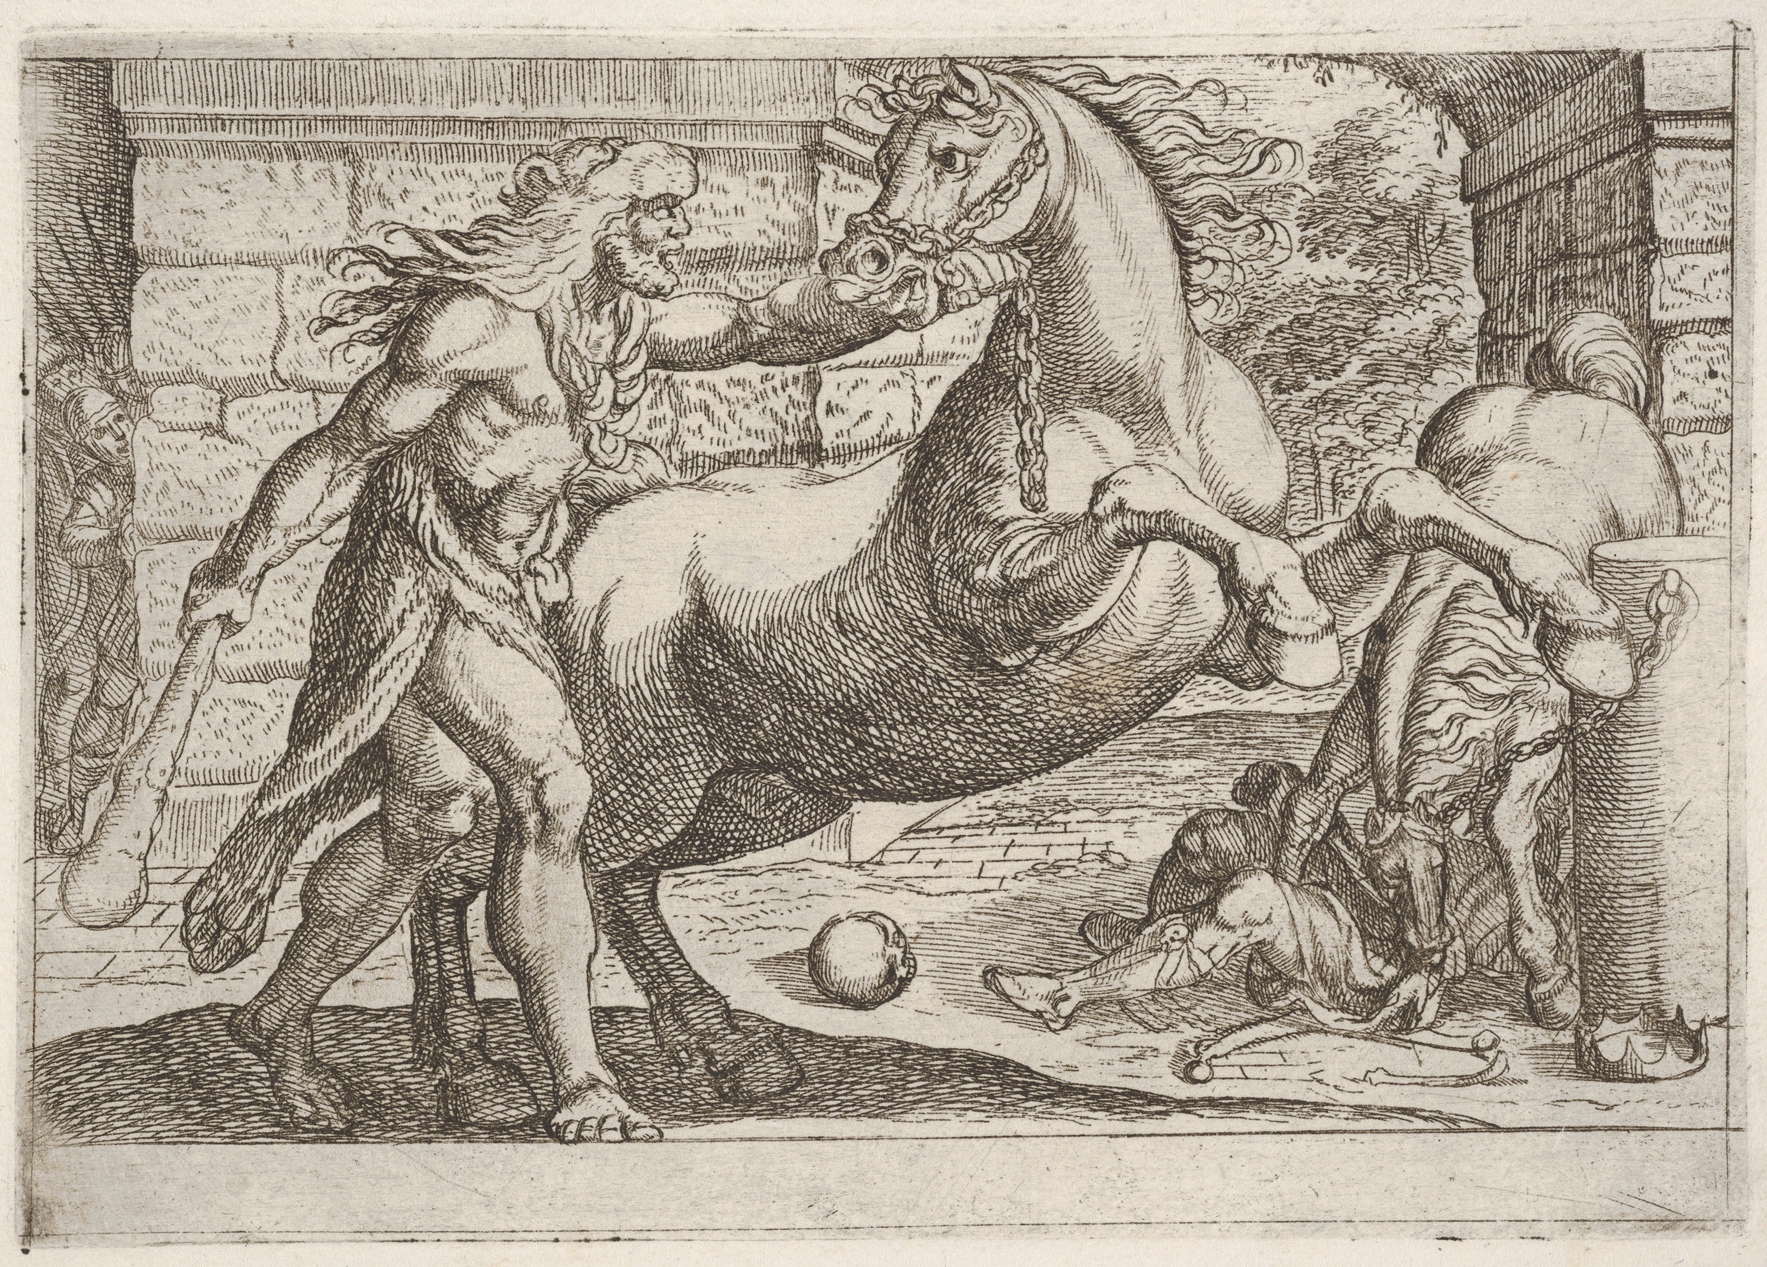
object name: print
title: Hercules and the Mares of Diomedes: Hercules grasps the bridle of a rearing horse, a second horse tramples a figure in at right, from "The Labors of Hercules"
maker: antonio tempesta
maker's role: artist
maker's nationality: italian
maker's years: 1555-1630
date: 1608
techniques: etching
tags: hercules,horses